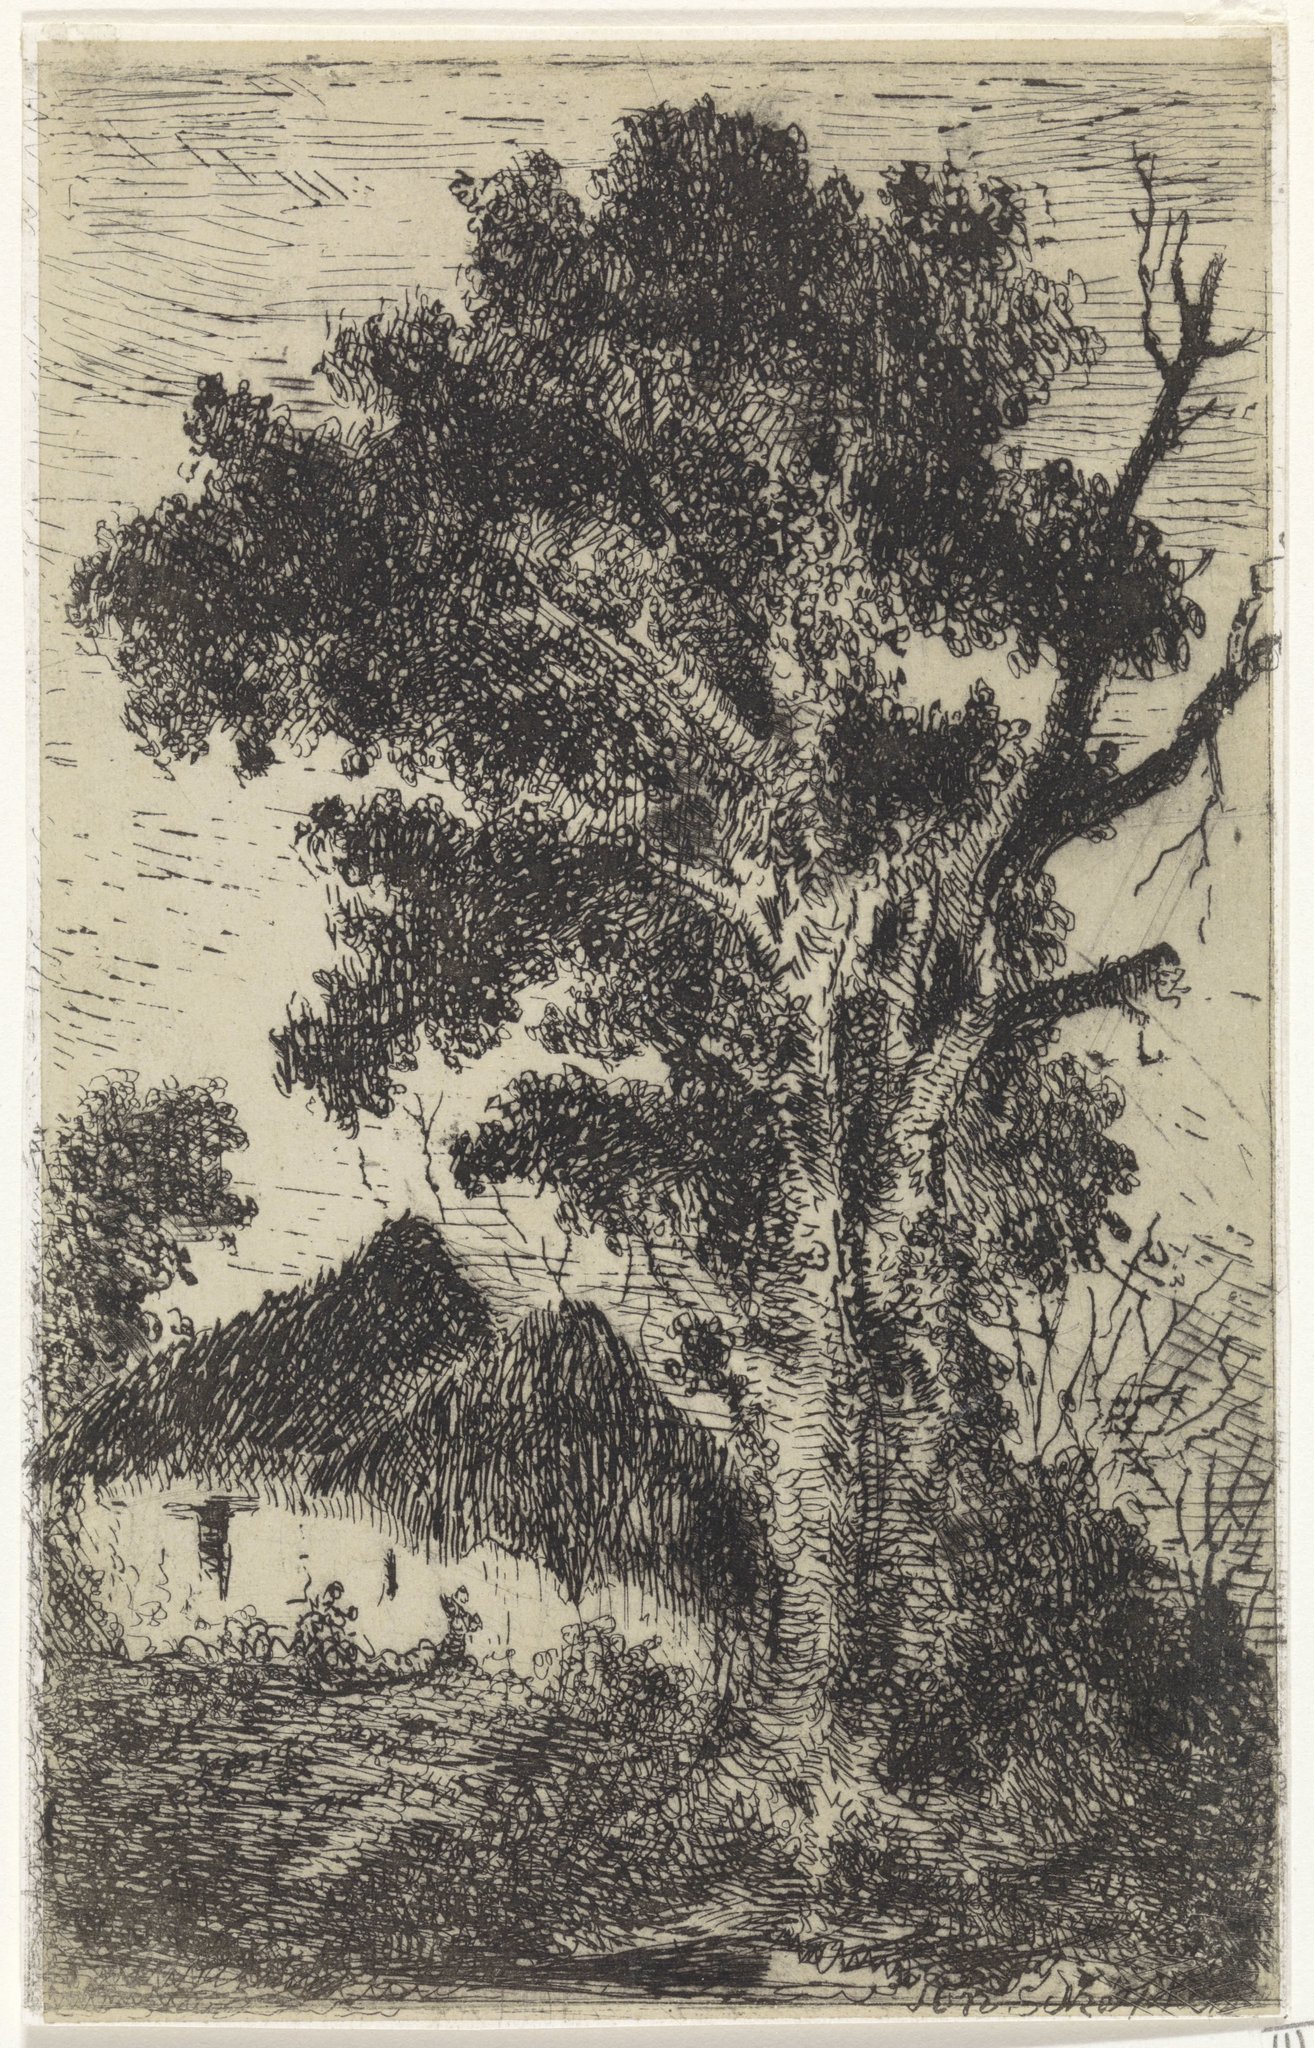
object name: print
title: Rietgedekte hutten onder een grote boom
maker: arnoud schaepkens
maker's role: print maker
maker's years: 1816-1904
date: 1831-1904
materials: paper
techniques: drypoint, etching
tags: landscapes, cottage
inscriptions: collector's mark: Lugt 2228